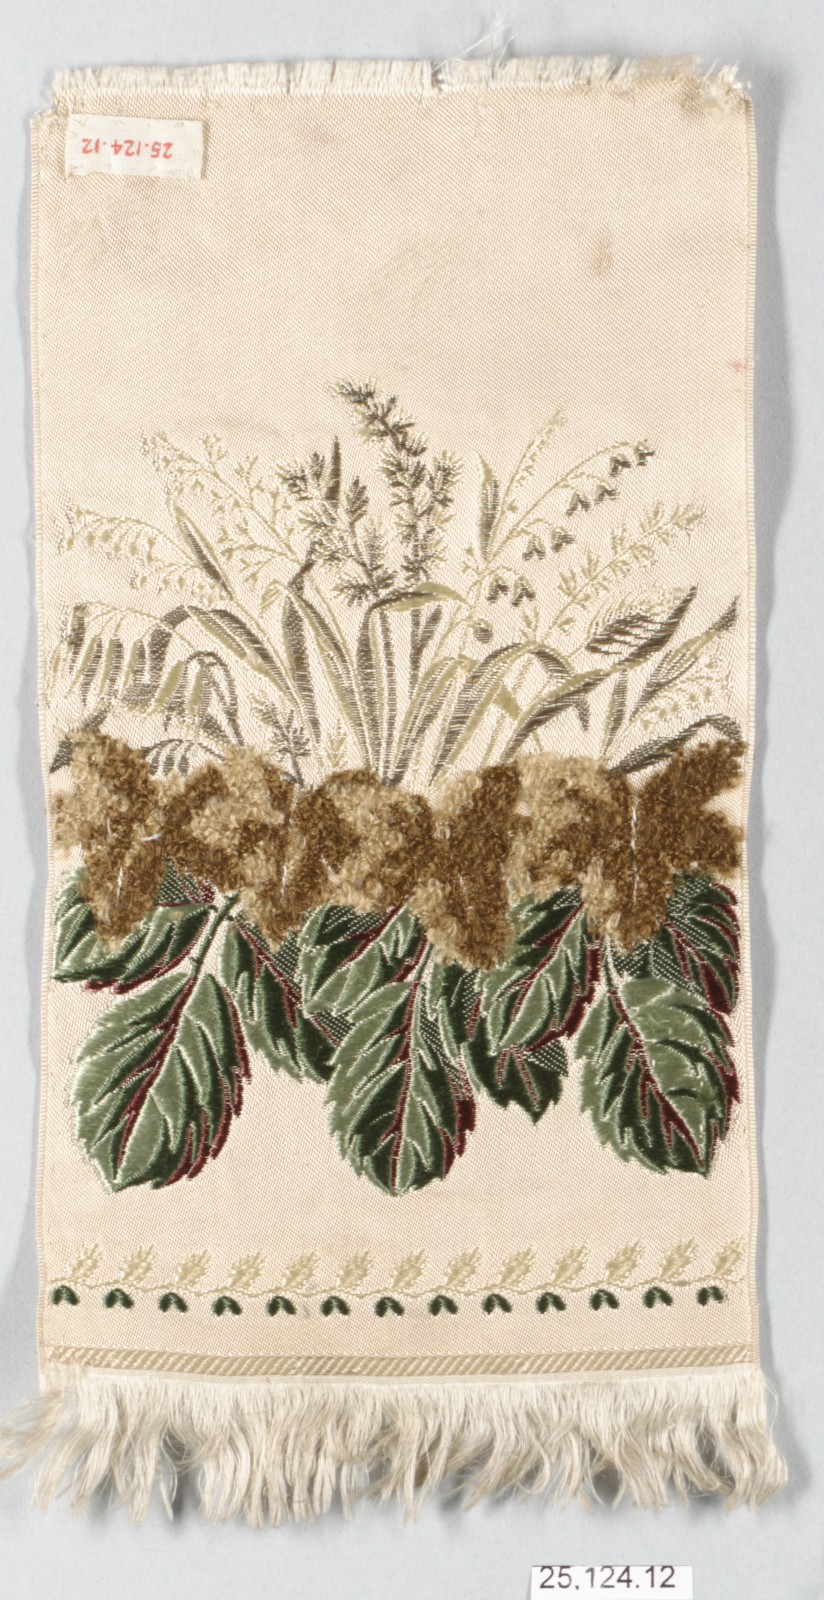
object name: necktie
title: Woman's necktie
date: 1870-1880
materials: metal thread, silk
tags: plants